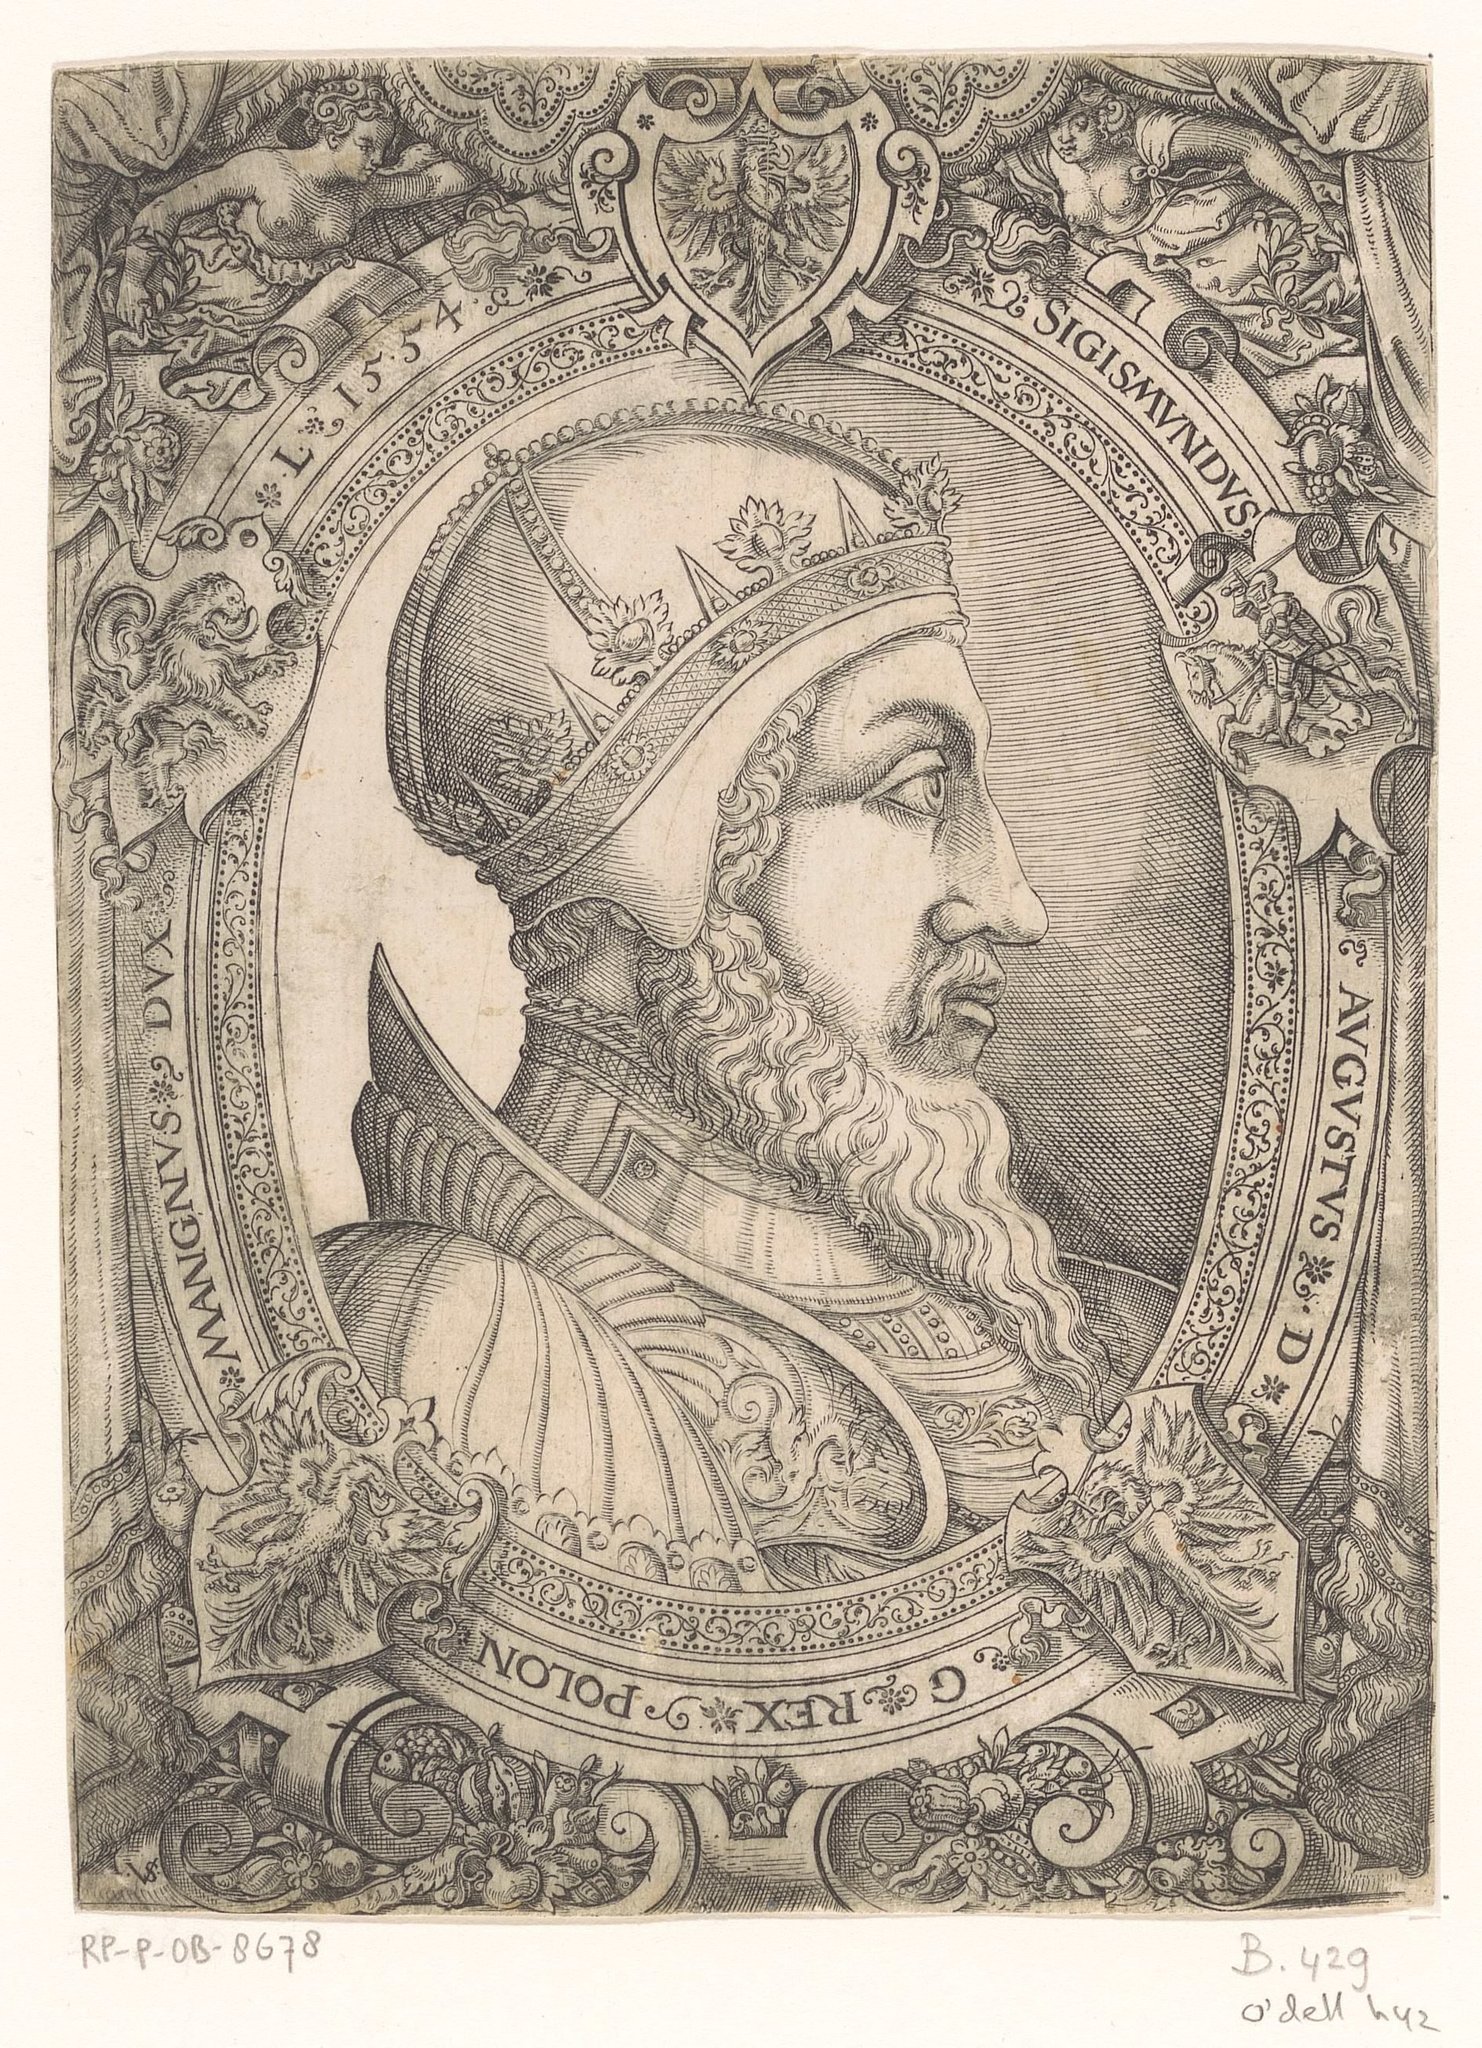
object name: print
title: Portret van Sigismund II August, koning van Polen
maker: virgilius solis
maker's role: draughtsman, print maker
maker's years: 1514-1562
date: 1554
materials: paper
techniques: engraving, etching, intaglio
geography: nuremberg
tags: scrollwork, strapwork ~ ornament, historical persons, armorial bearing, heraldry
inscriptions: number: ‘159’, collector's mark: Lugt 2228